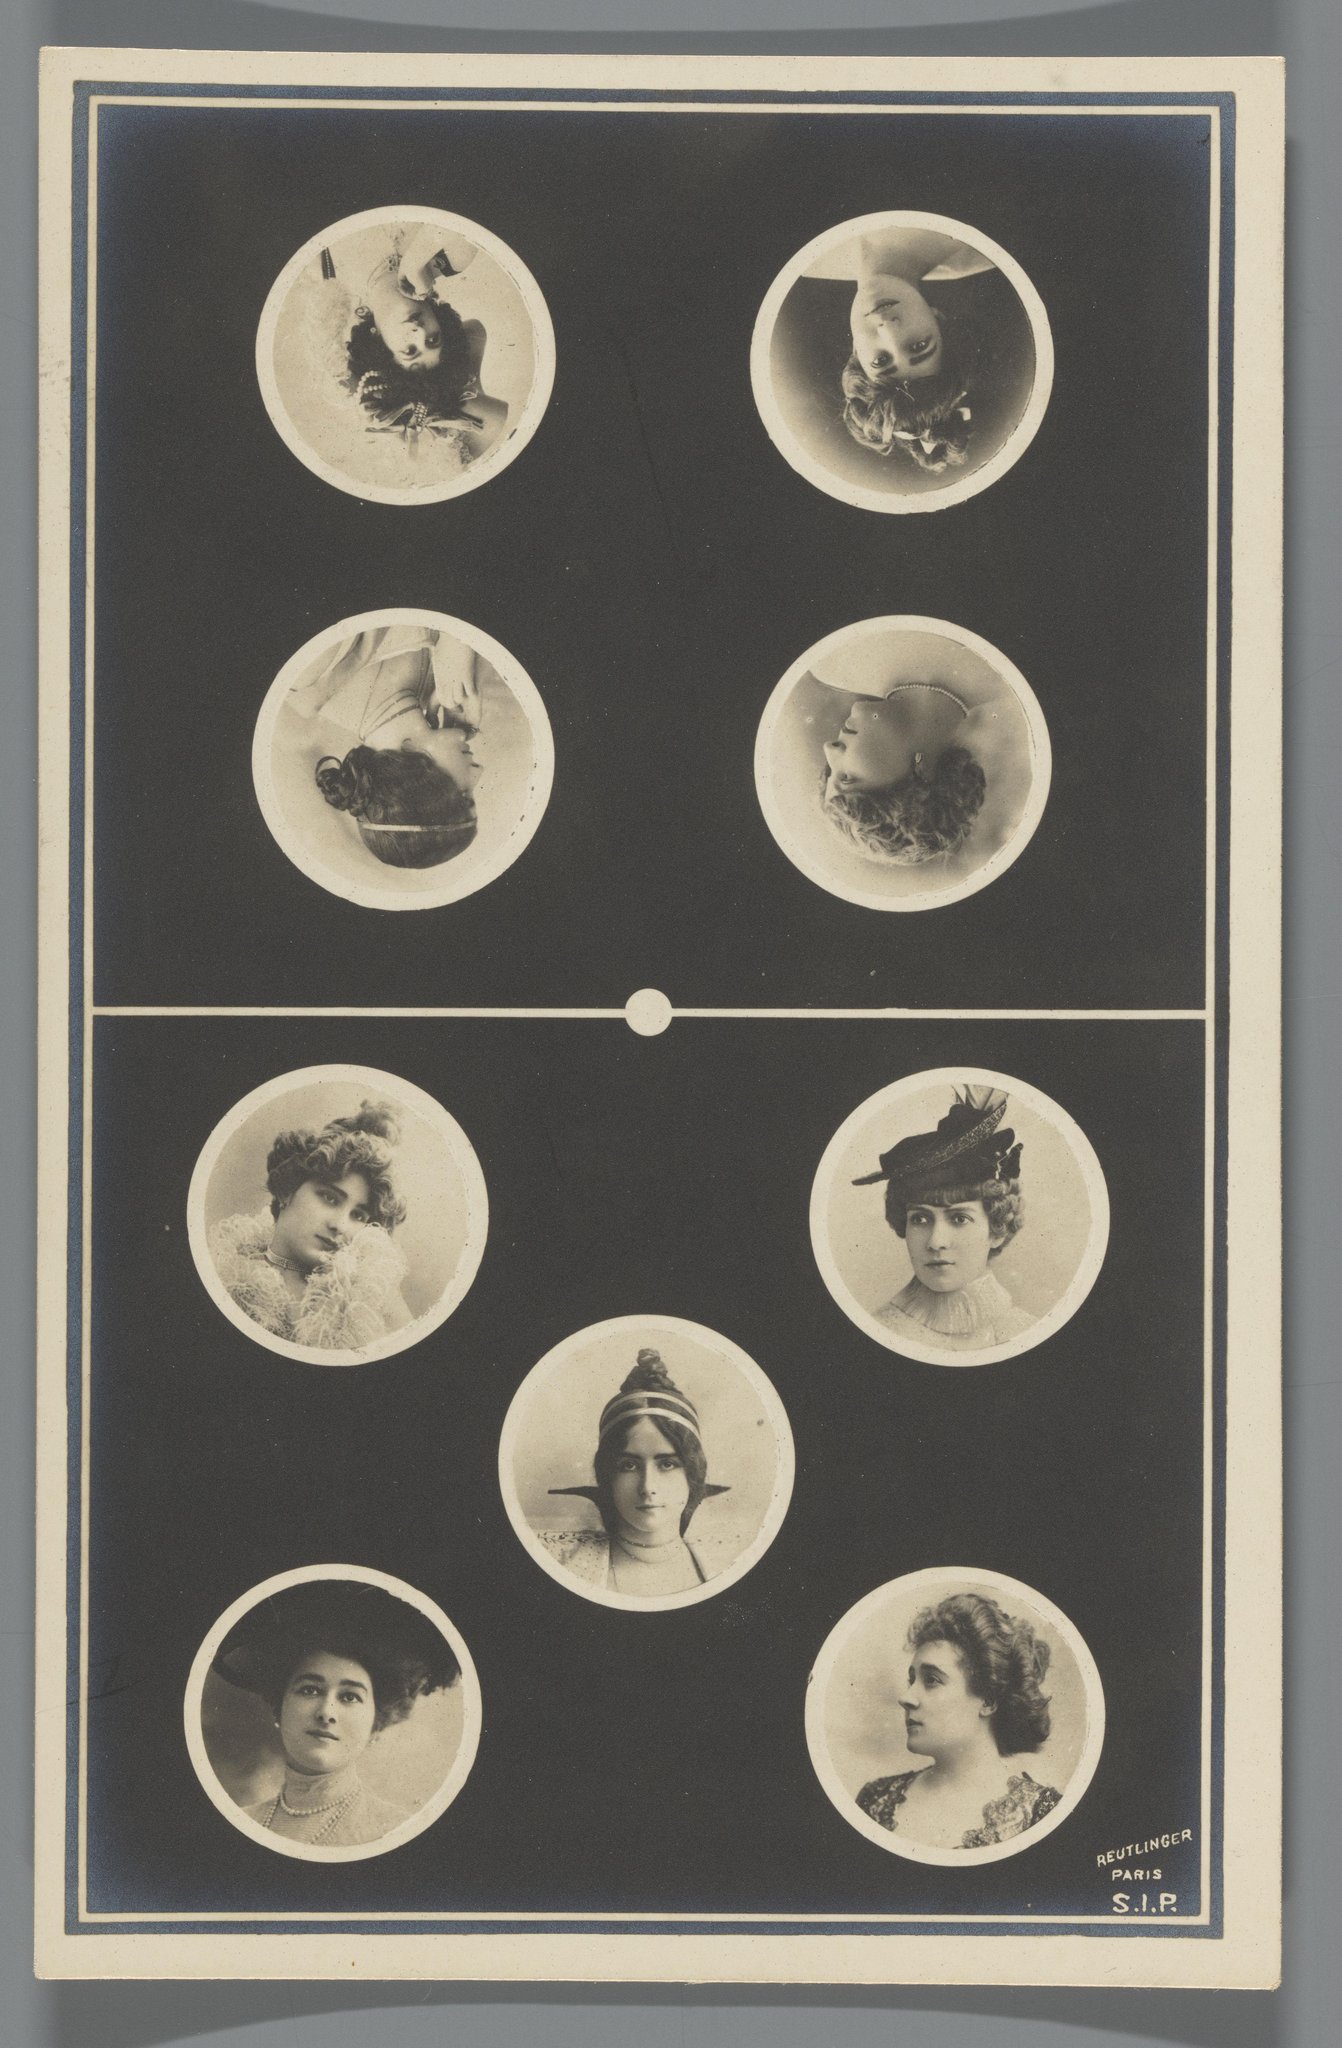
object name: ansichtkaart, prentbriefkaart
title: Prentbriefkaart met 9 portretten van Cléo de Mérode en andere actrices/danseressen [?], gecomponeerd als domino-steen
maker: reutlinger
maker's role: fotograaf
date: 1900-1910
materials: photographic support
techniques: gelatin silver print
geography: paris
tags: actrice, cléo de mérode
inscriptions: inscription: ‘ […] CARTE POSTALE […]’, inscription: ‘REUTLINGER / PARIS / S.I.P.’